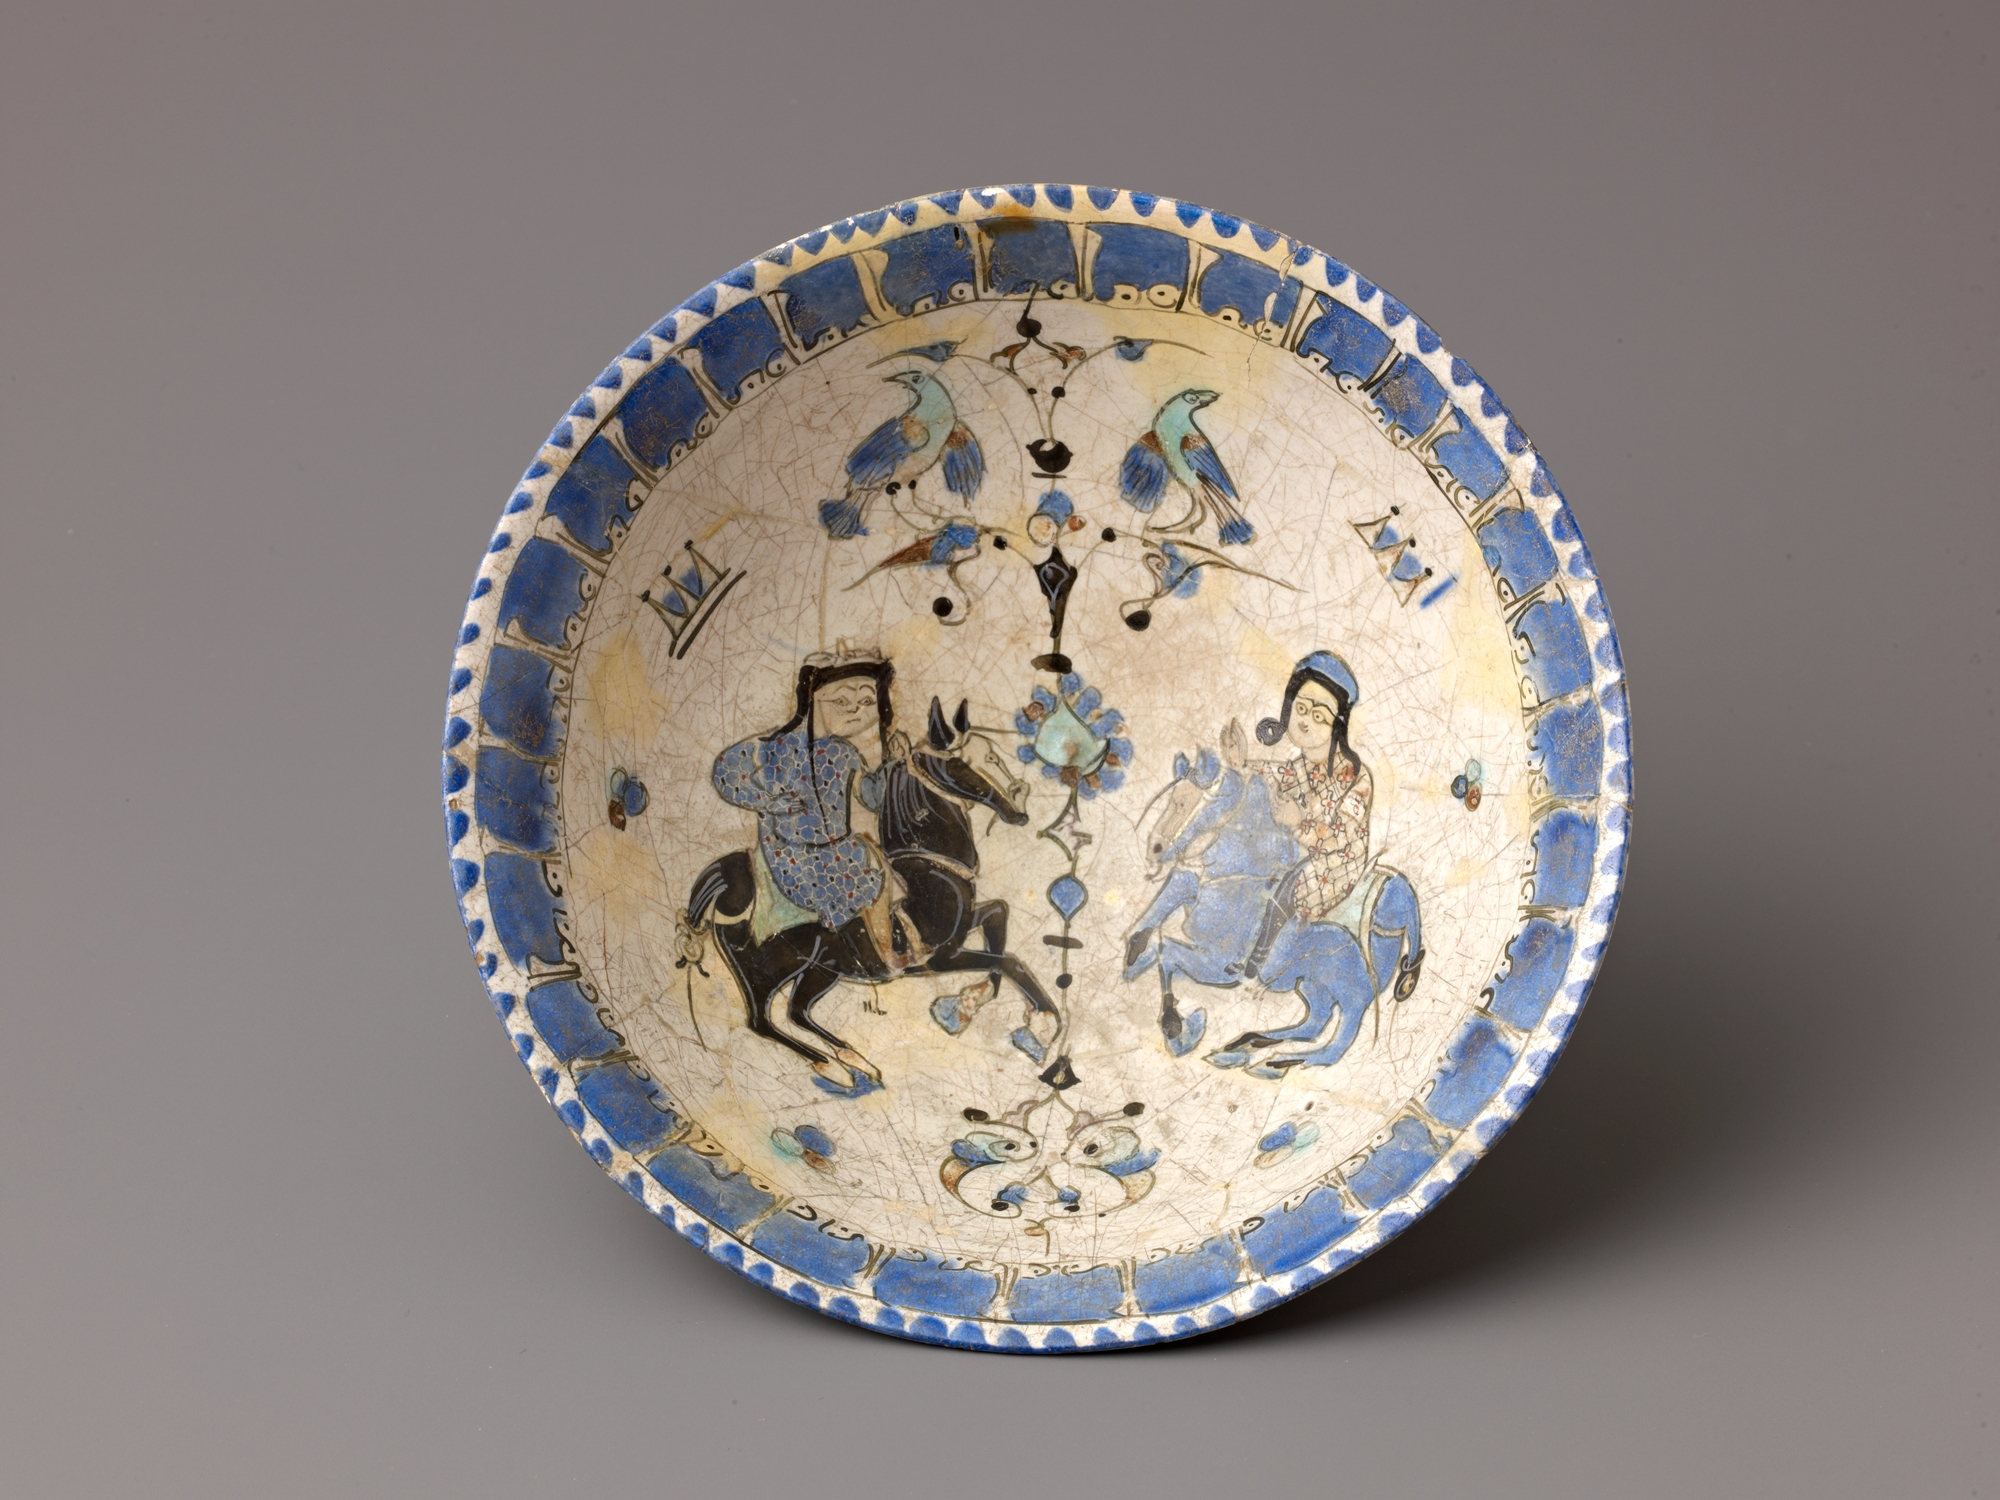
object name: bowl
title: Bowl, Mina'i ("enameled") ware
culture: iranian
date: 1201-1233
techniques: gilding, overglaze, painting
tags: birds,men,horses